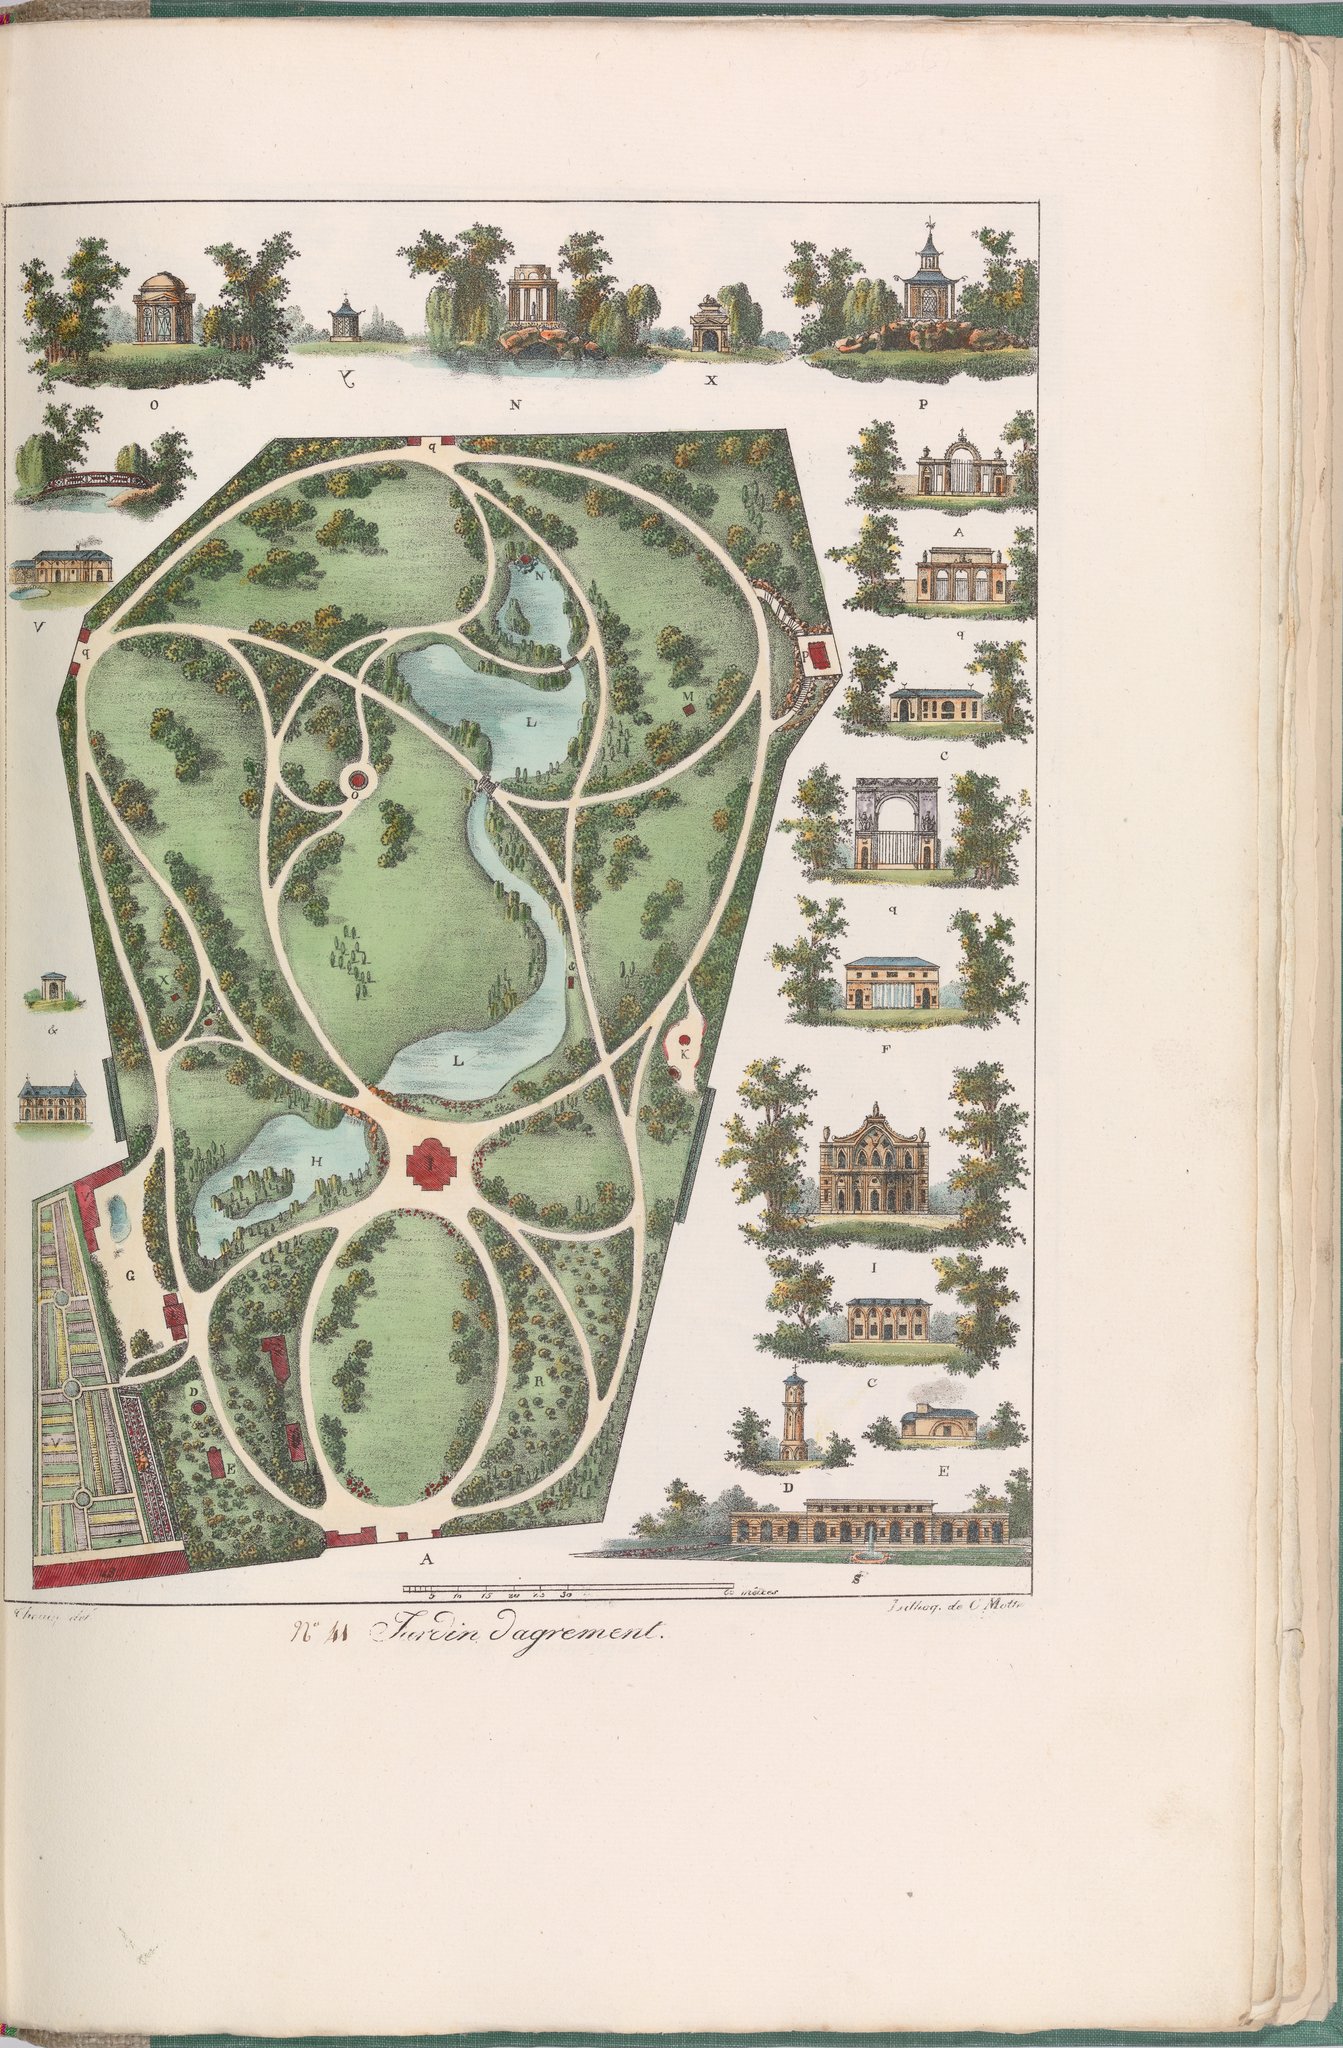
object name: book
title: Plans Raisonnés de Toutes les Espèces de Jardins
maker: gabriel thouin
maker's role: designer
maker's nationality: french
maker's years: 1747-1829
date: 1820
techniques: hand coloring, lithograph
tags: gardens